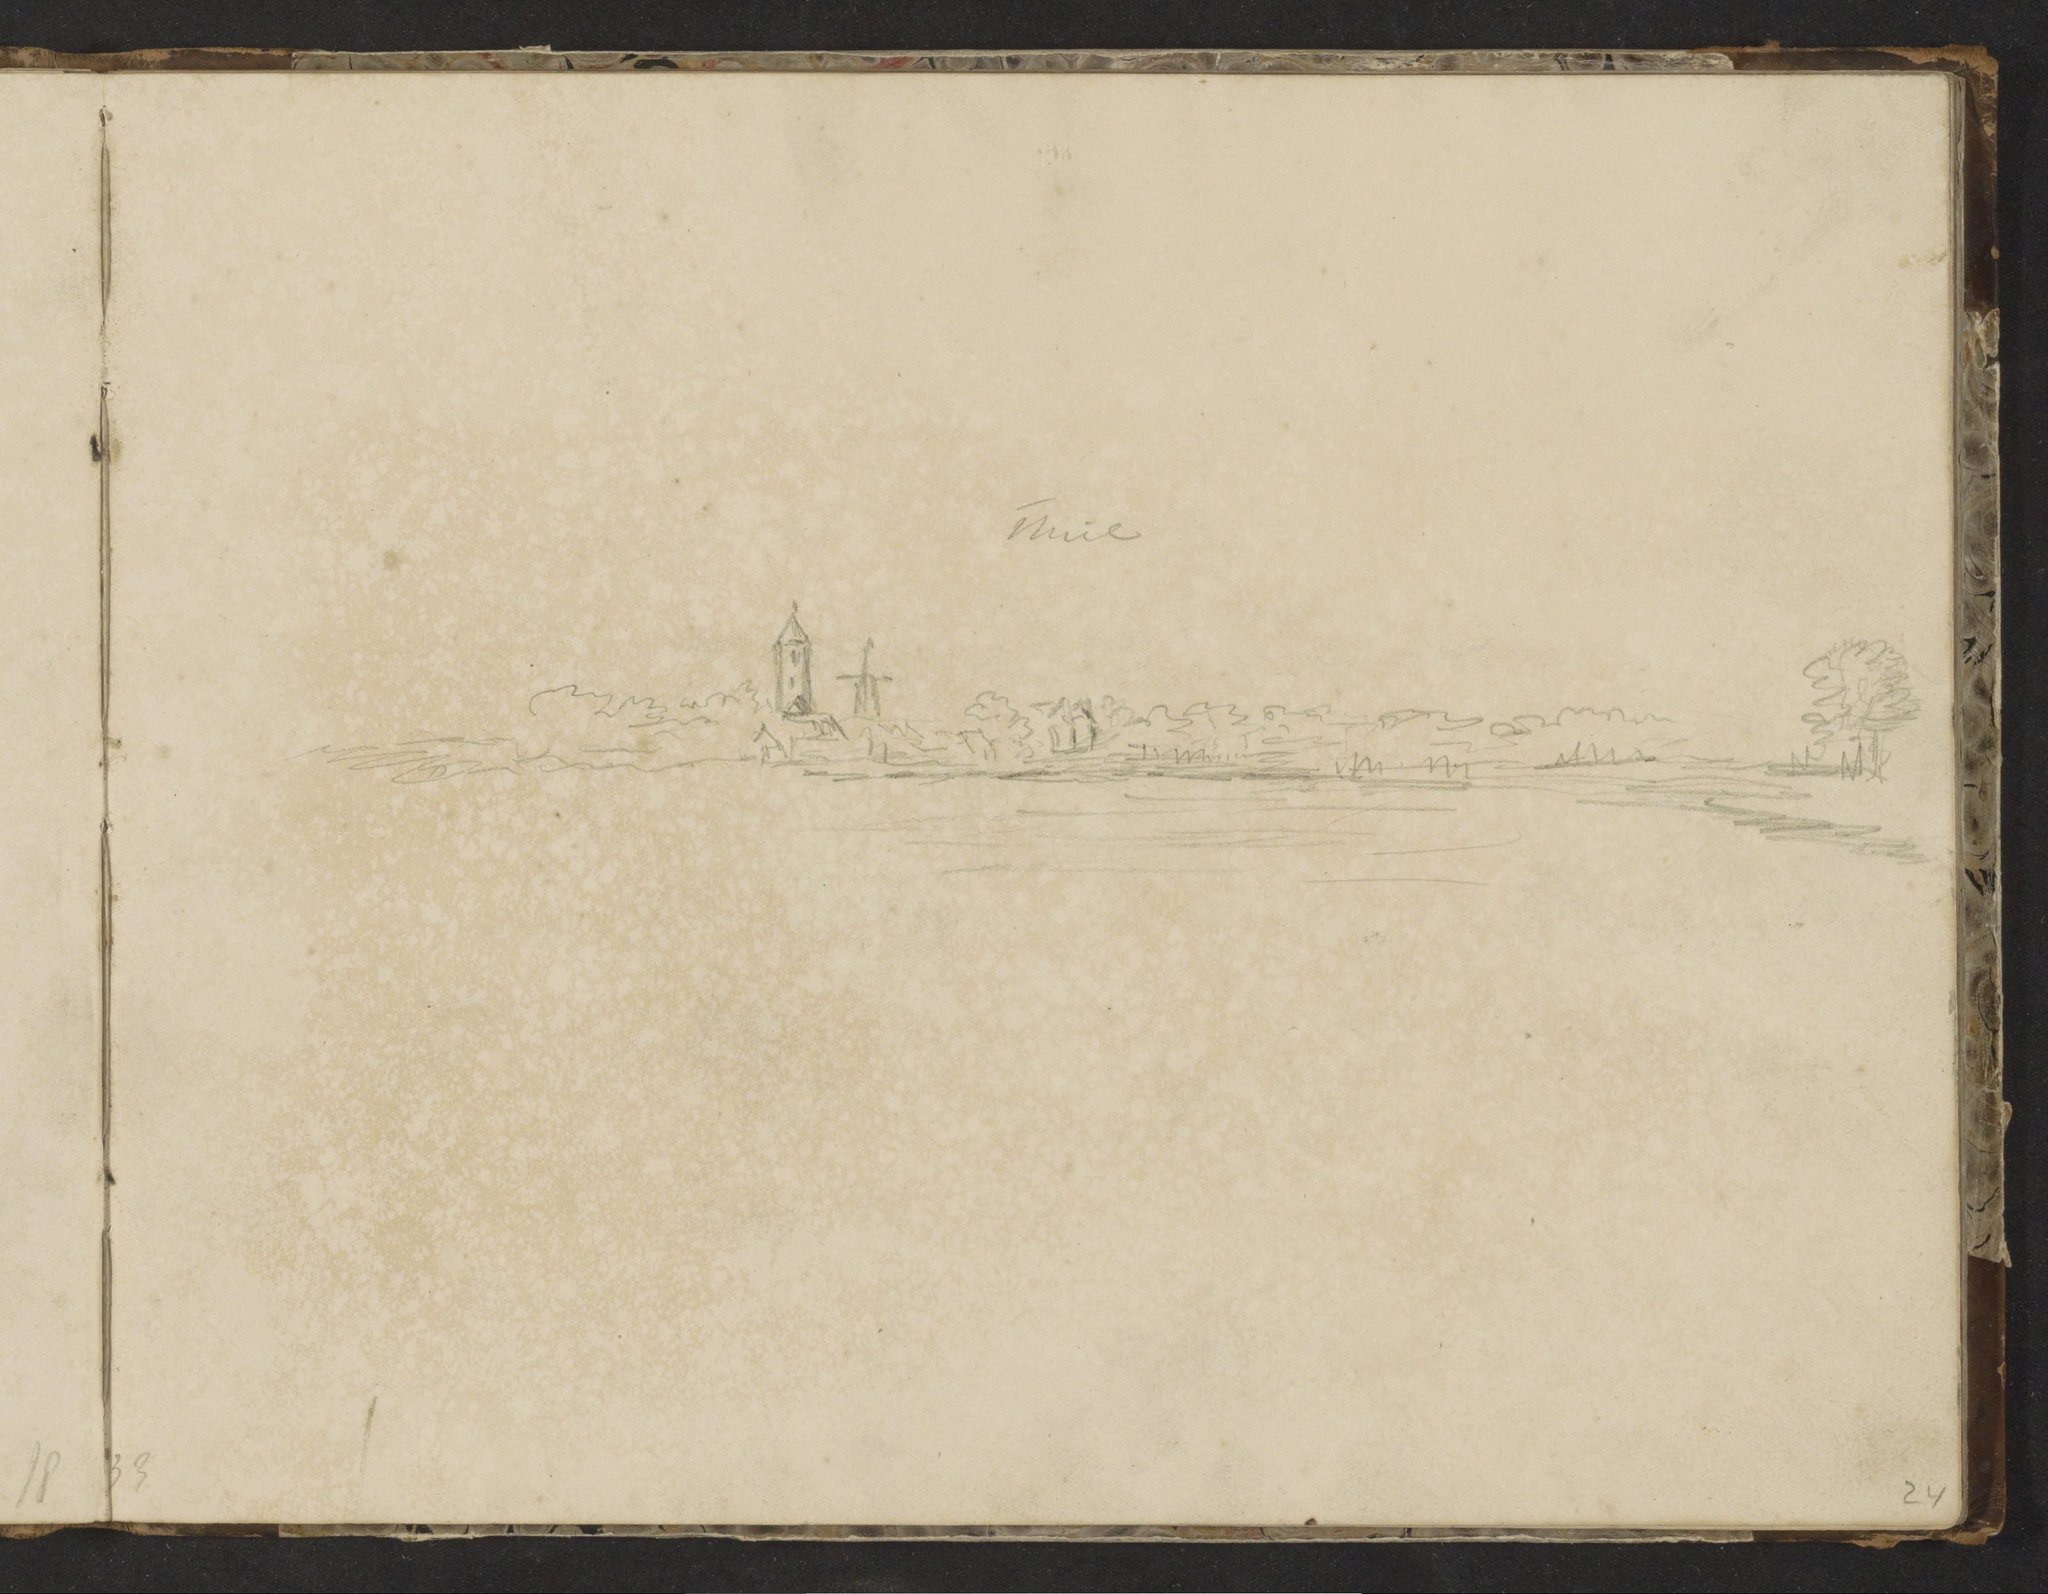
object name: sketchbook leaf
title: Gezicht op Tiel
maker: johannes tavenraat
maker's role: draughtsman, painter, print maker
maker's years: 1809-1881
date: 1833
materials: paper, pencil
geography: tiel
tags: city-view, and landscape with man-made constructions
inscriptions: date and inscription: ‘Tiel/ 33’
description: Blad 24 recto uit een schetsboek met 41 bladen.